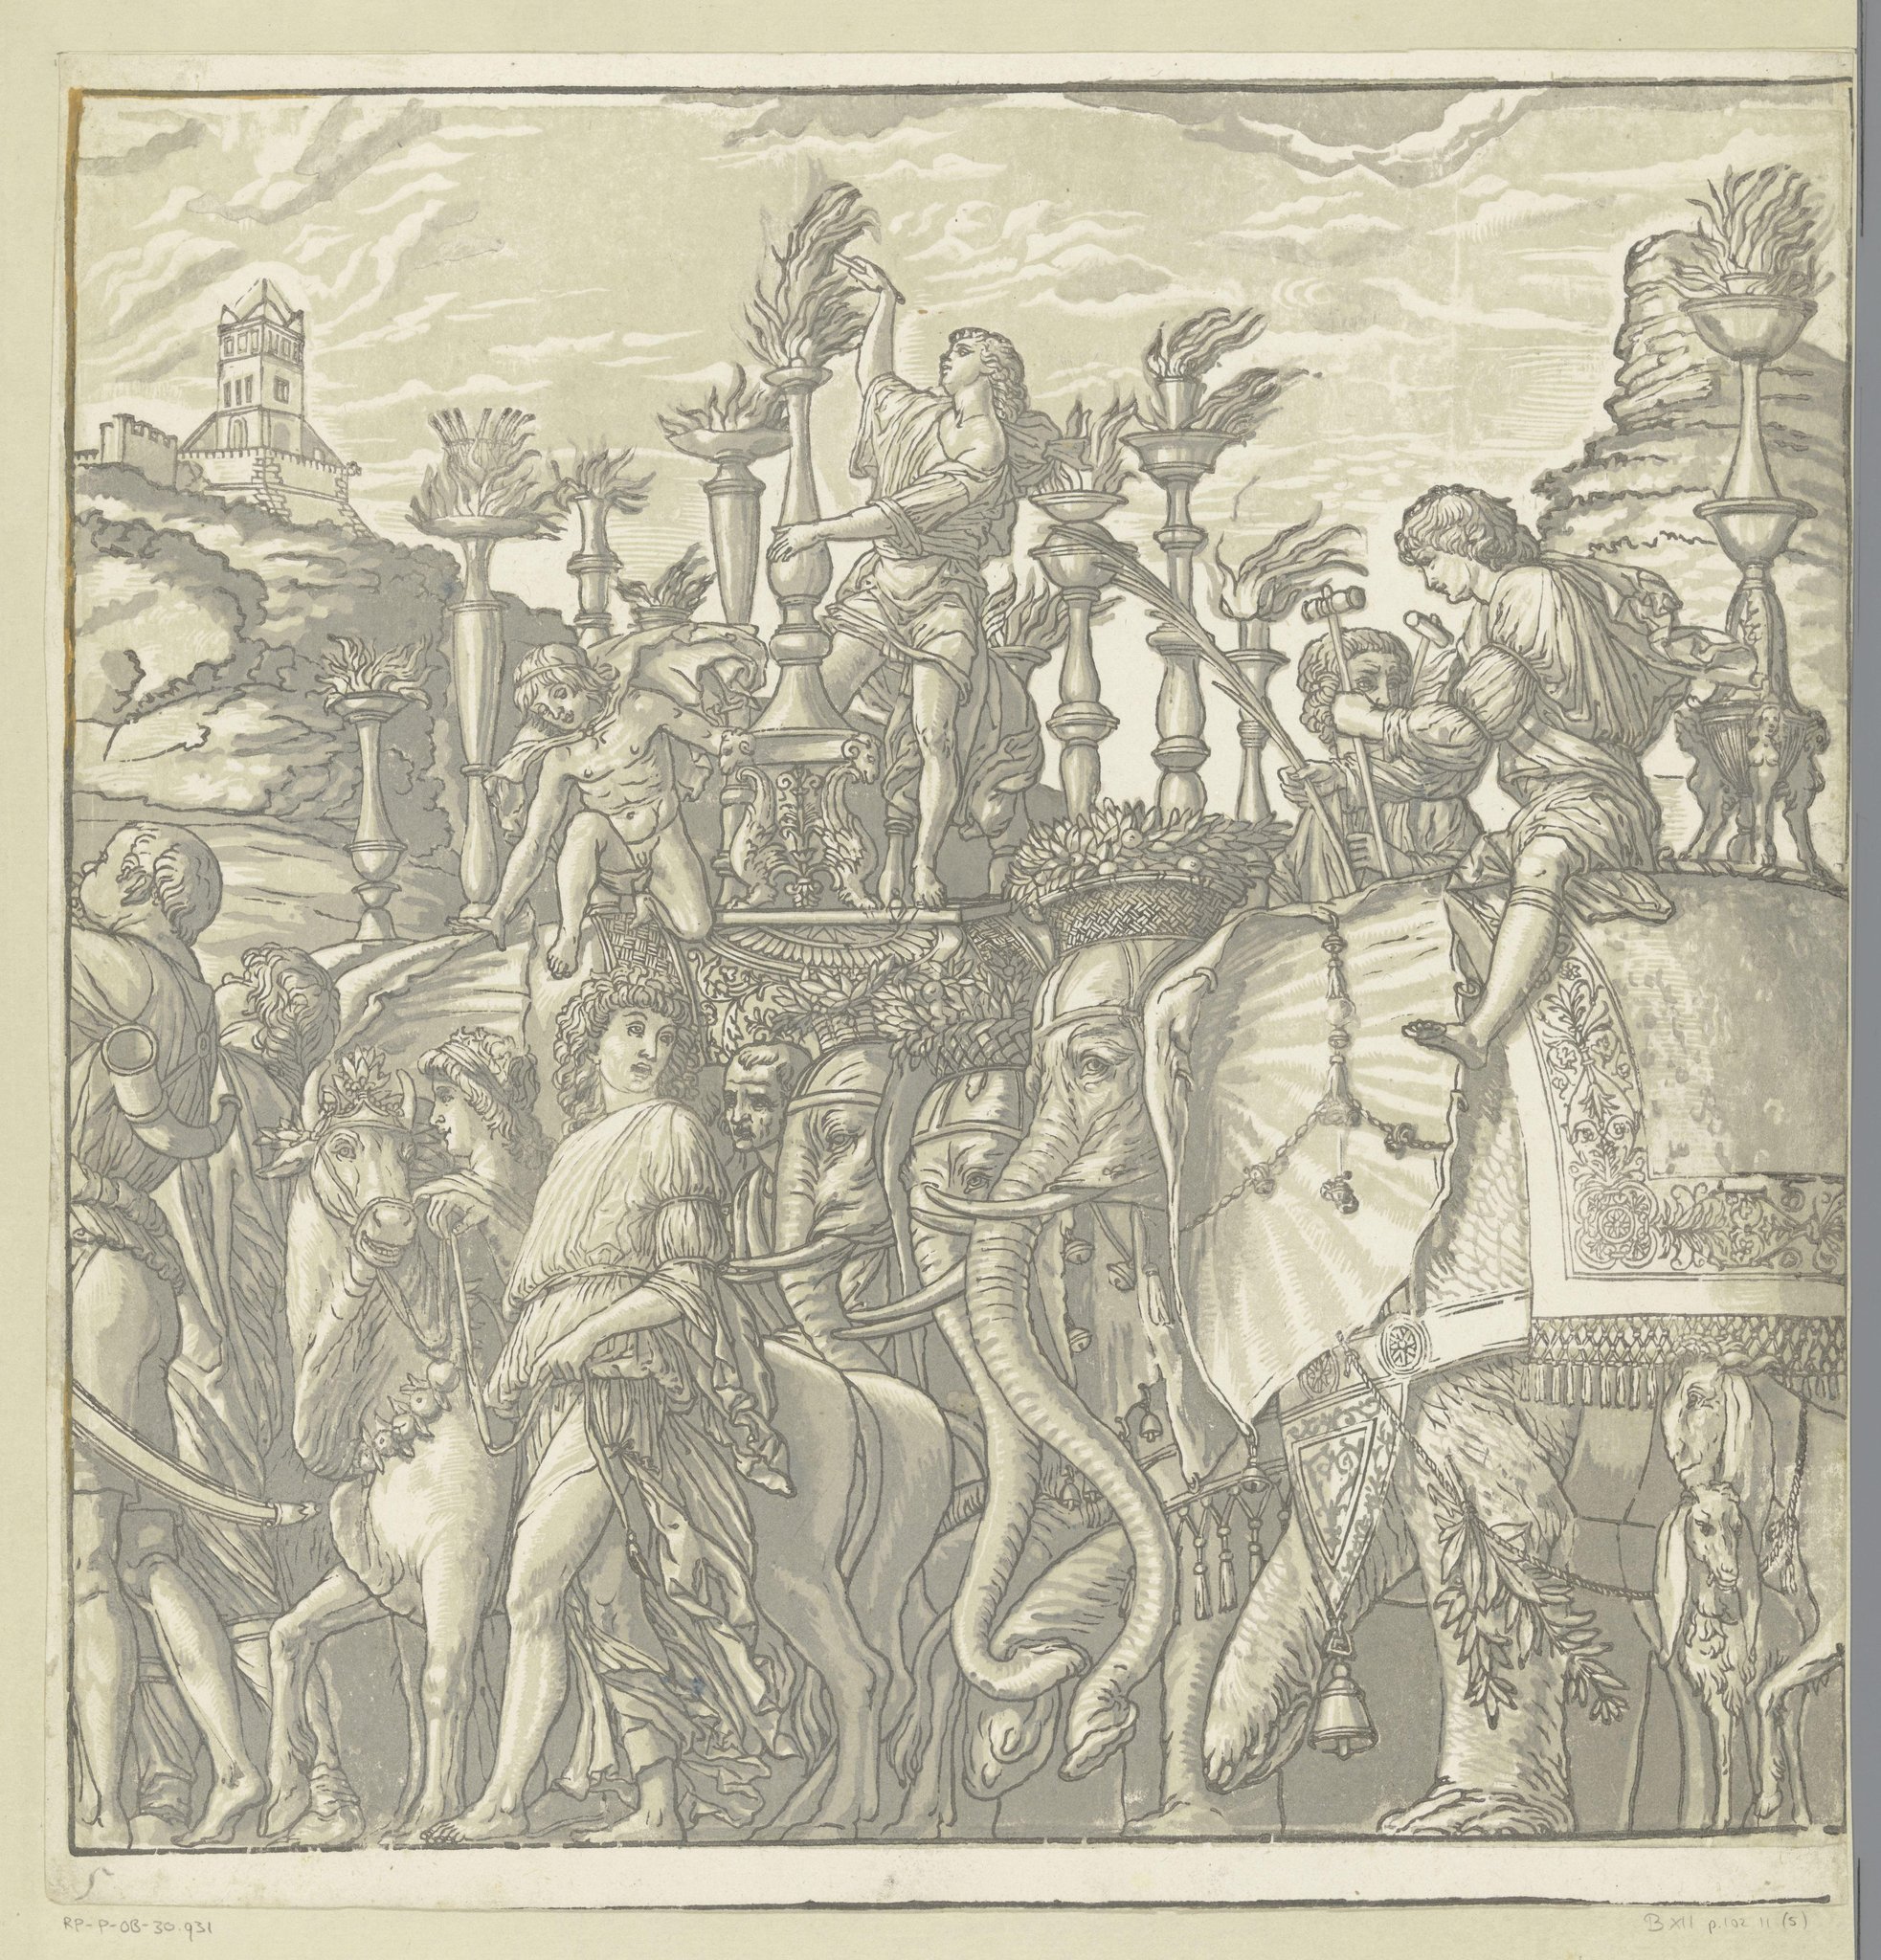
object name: print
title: Triomftocht van Julius Caesar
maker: andrea andreani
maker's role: print maker, printer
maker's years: 1558-1629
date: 1599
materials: paper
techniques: woodcut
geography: mantua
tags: torch, triumph of caesar, trunked animals: elephant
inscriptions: number: ‘5’, collector's mark: Lugt 240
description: Deze prent maakt deel uit van een fries dat bestaat uit een titelprent en negen prenten die samen een triomftocht van Julius Caesar vormen. Bij de serie hoort tevens een prent met daarop zes Korinthische pilasters, bedoeld om te worden uitgeknipt en gebruikt als verbindingsstukken tussen de verschillende bladen.